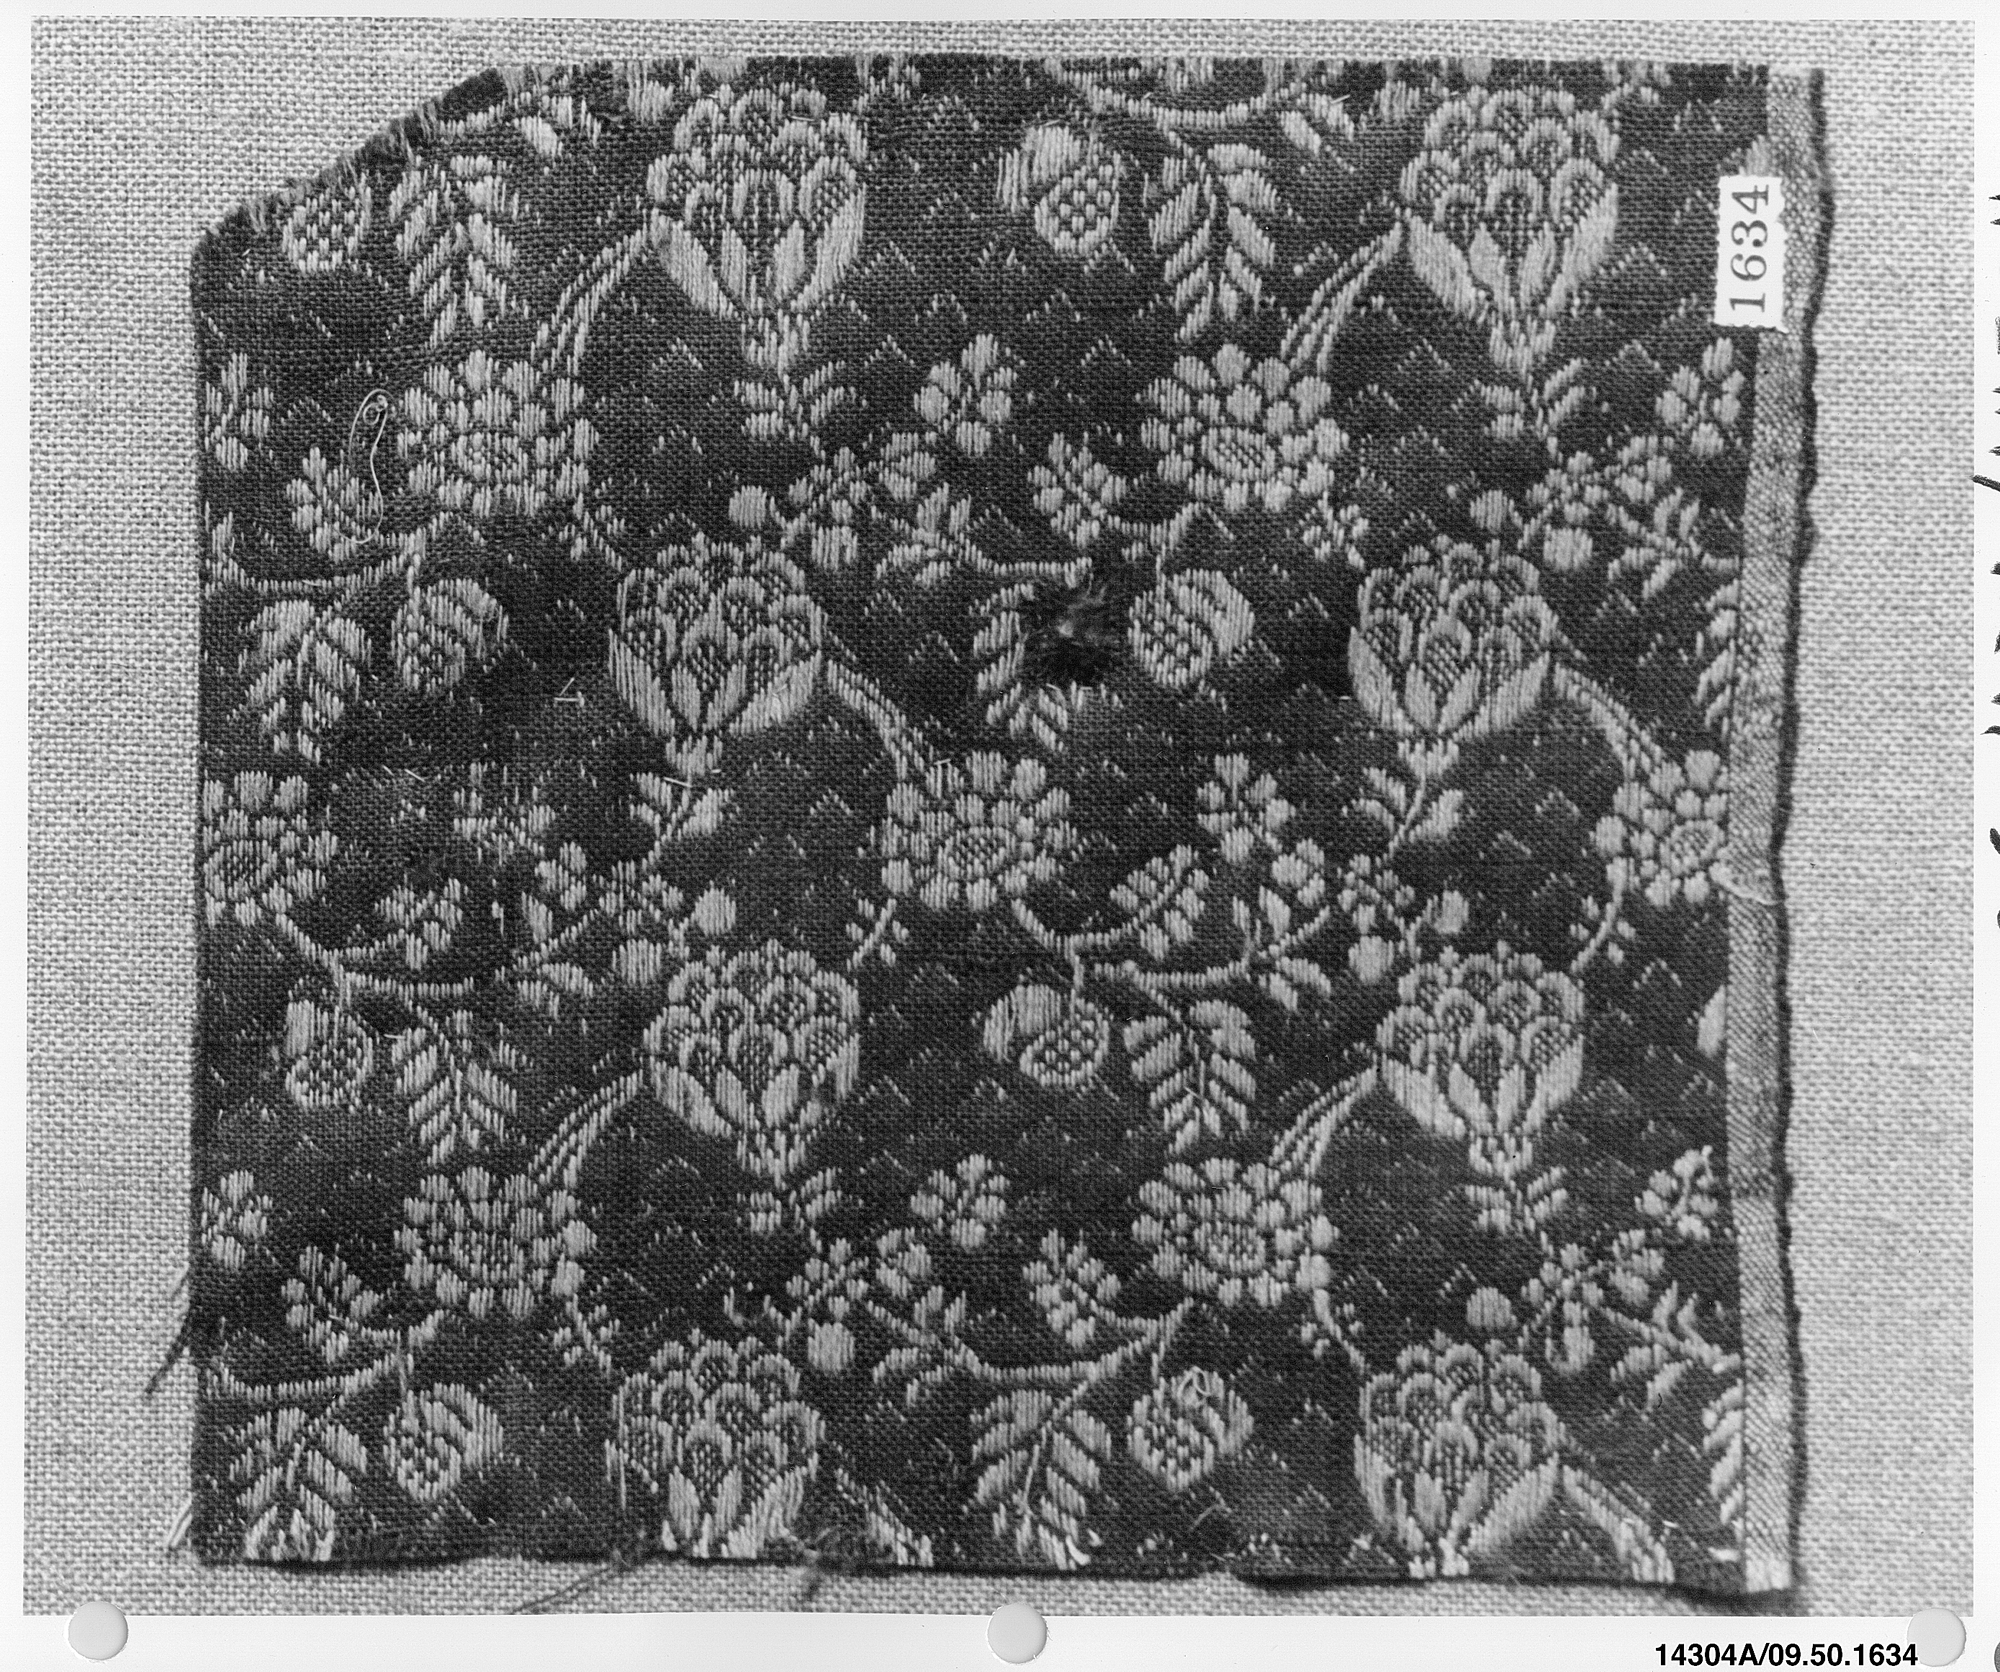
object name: fragment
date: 1801-1900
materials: wool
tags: flowers,leaves